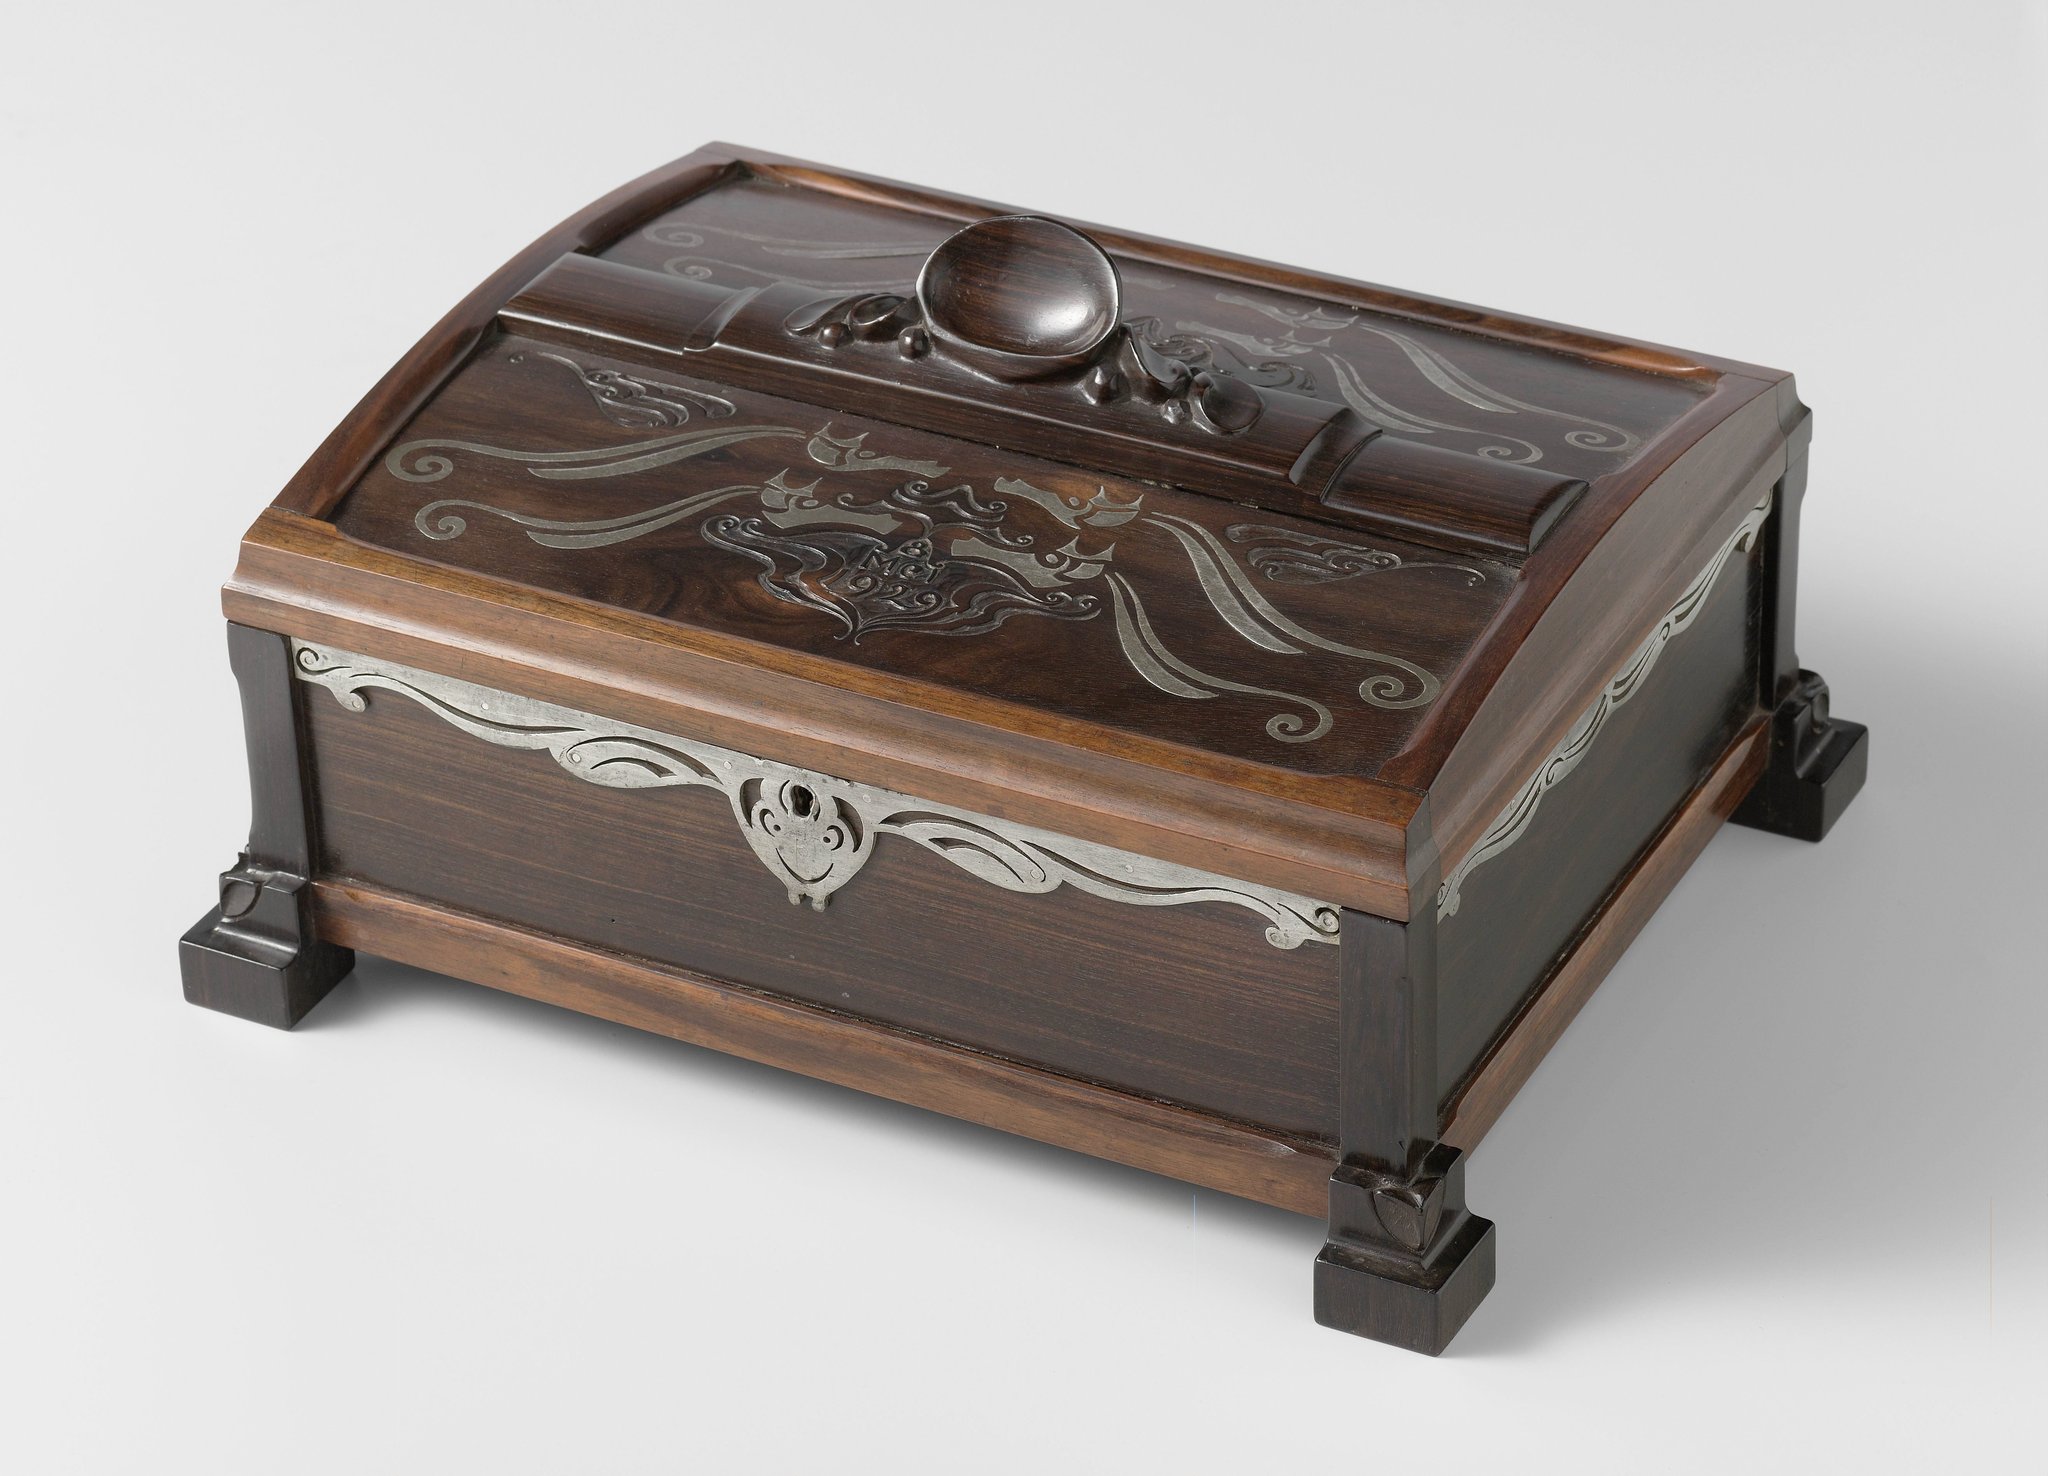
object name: chest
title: Casket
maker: anton fortuin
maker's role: sculptor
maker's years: 1880-1967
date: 1929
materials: wood, tin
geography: northern netherlands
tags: bony fishes: hippocampus, ornament ~ cartouche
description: Kist van coromandelhout, ingelegd met tin en met tinnen beslag, rustend op dubbel vierkante poten. De kist heeft uitgestoken hoeken en regels. De zijkanten zijn bovenaan voorzien van golvend tinnen beslag; de sleutelplaat aan de voorzijde is hierin opgenomen. Het gebolde deksel heeft een middenregel, waarop een greep in de vorm van een schelp. De twee panelen zijn ieder ingelegd met vier gestileerde toegewende zeepaarden, waartussen snijwerk met de initialen AF en 8 mei 1929, binnen een cartouchevorm.